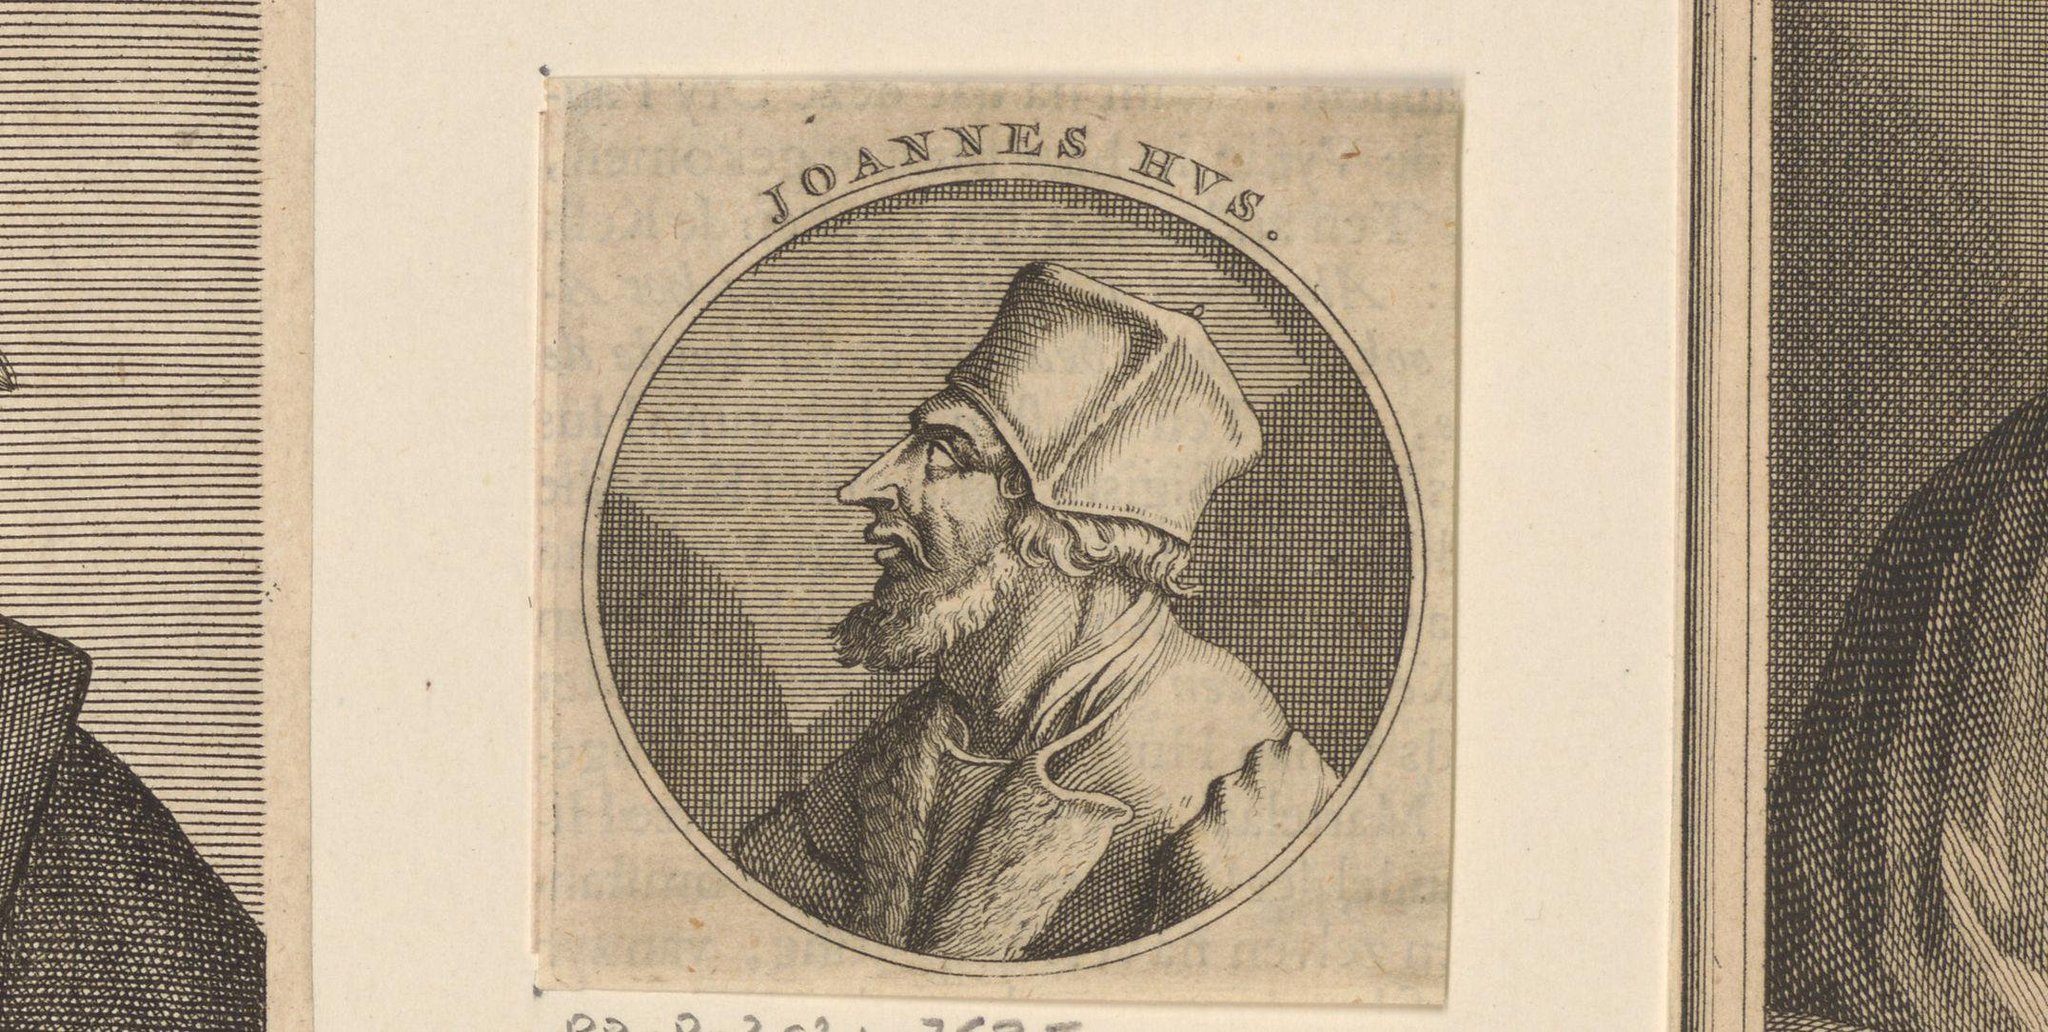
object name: book illustration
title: Portret van Johannes Hus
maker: Anonymous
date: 1705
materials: paper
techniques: etching, letterpress printing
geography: amsterdam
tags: theologian, historical persons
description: Prent uit: Goeree, Willem. De kerklyke en weereldlyke historien; uyt d'aal-ouwde aardbeschryving (...). Amsterdam: Gerardus en Jacobus Borstius, 1705, p. 584.